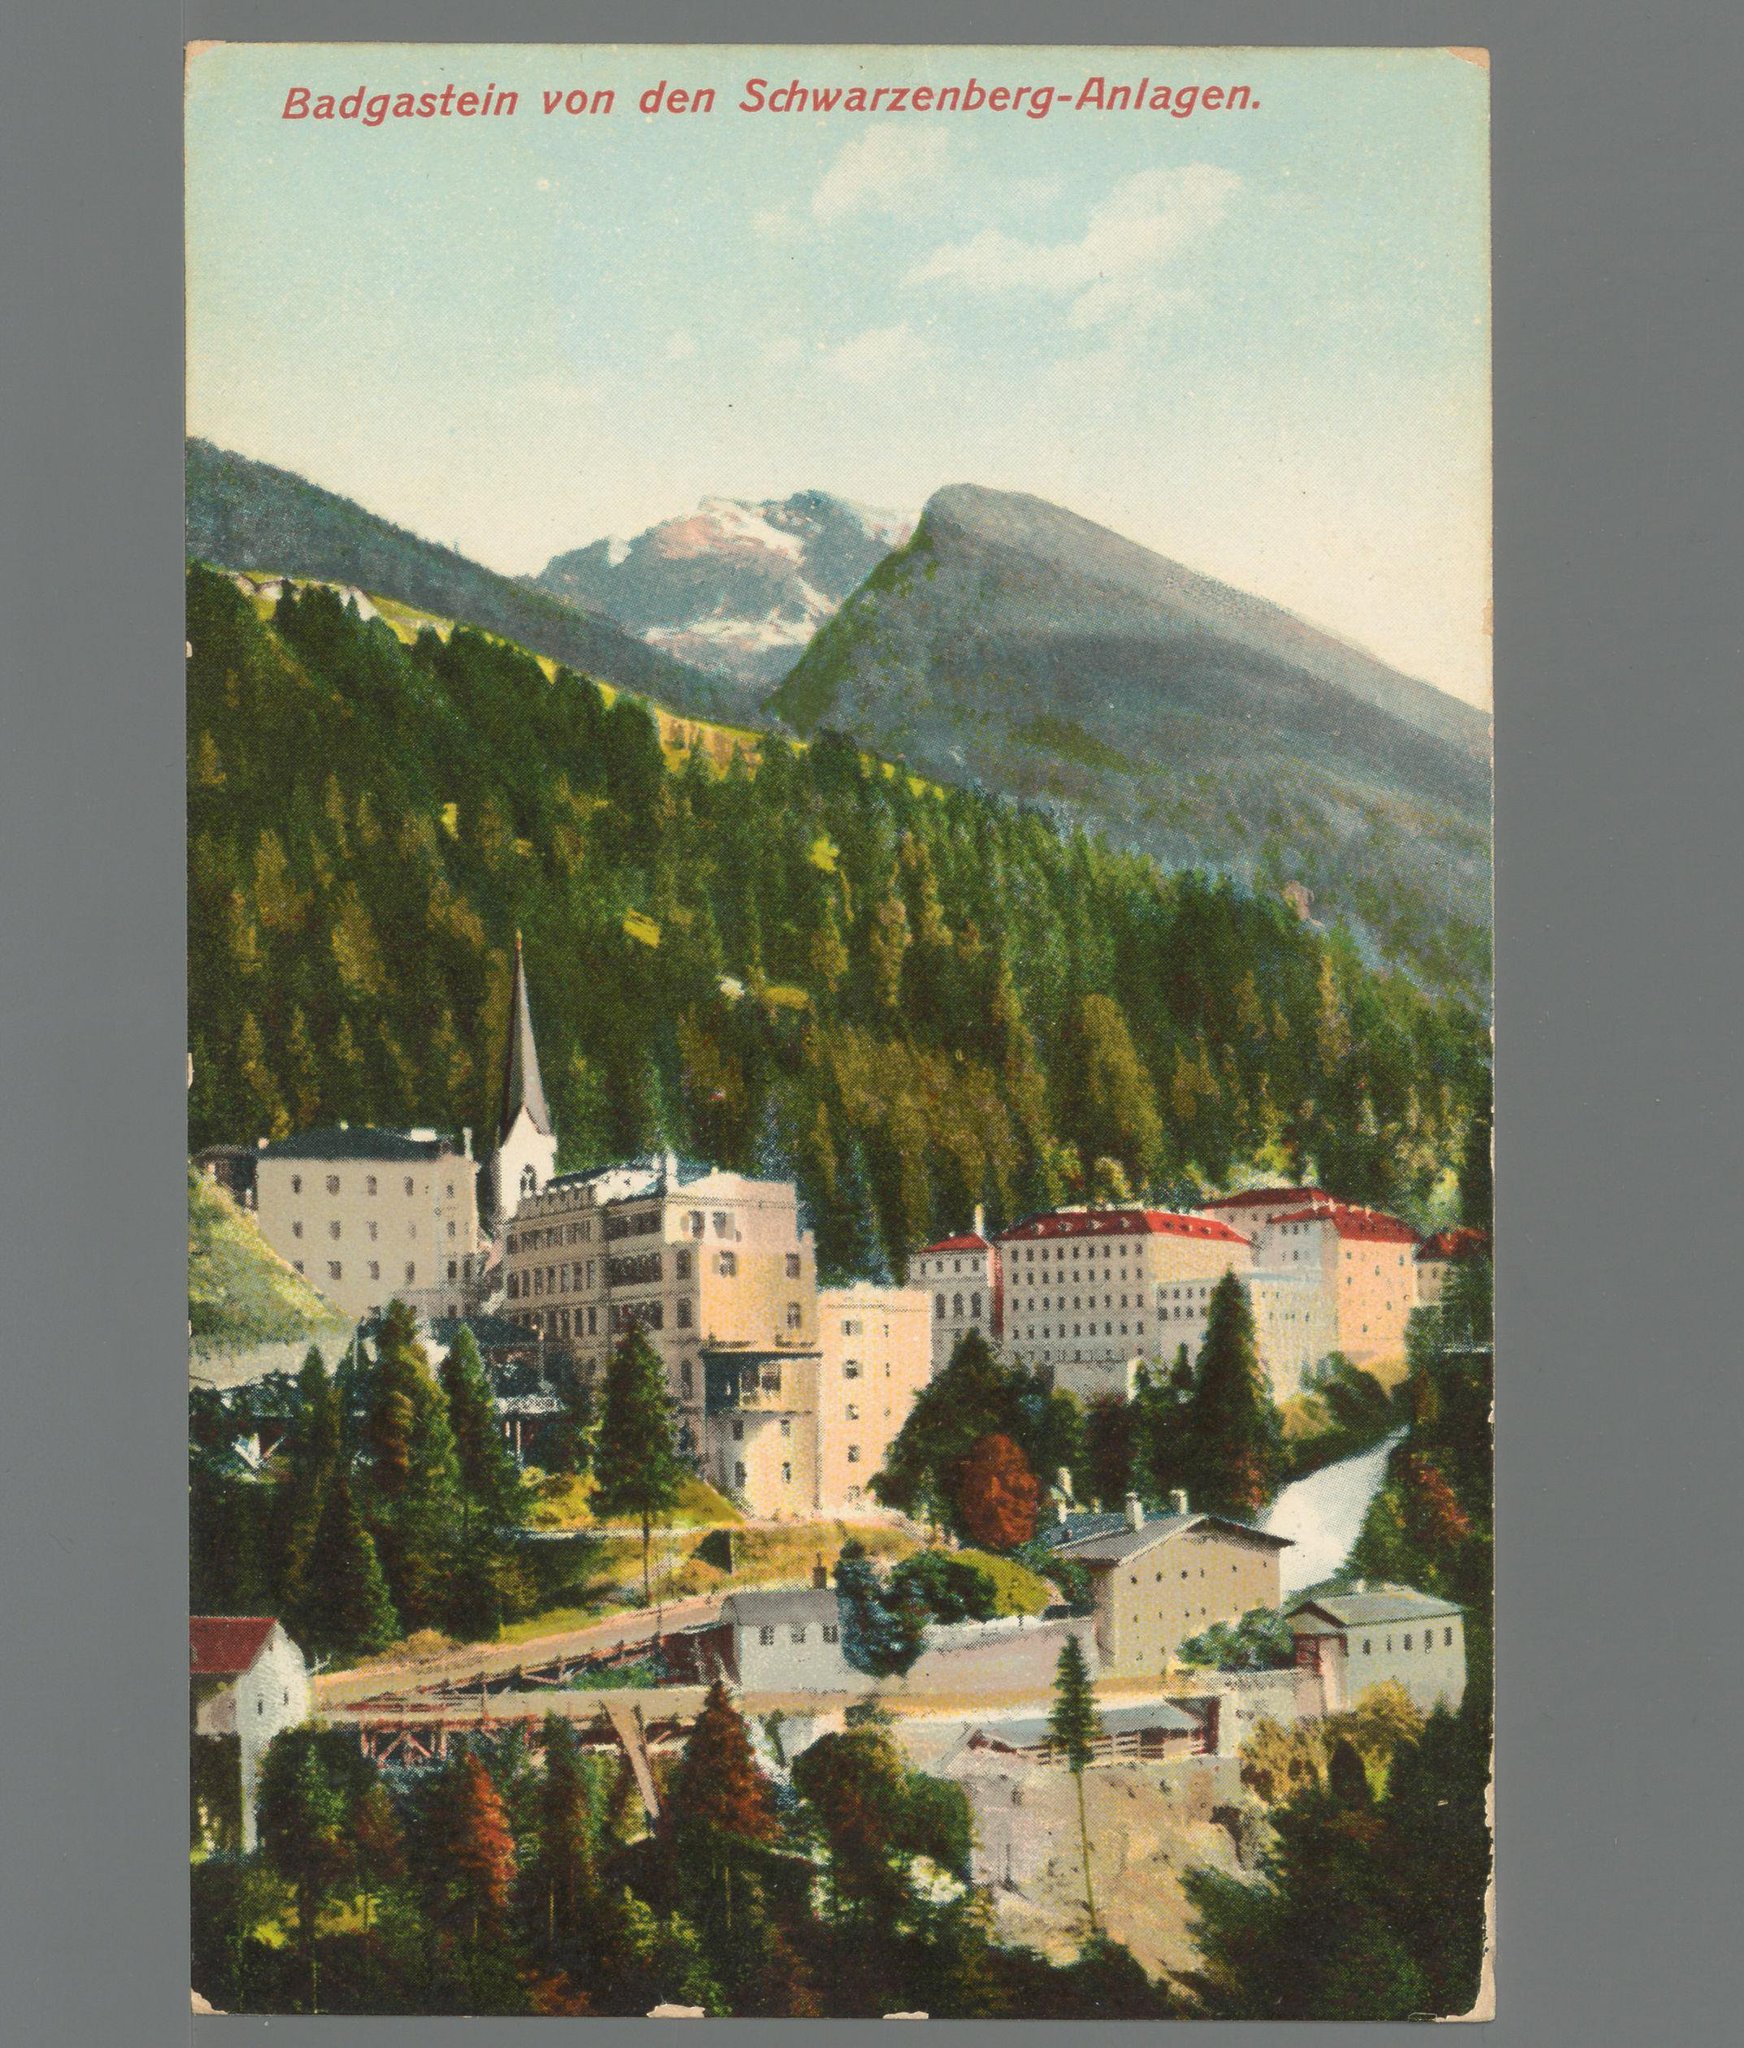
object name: ansichtkaart, prentbriefkaart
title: Badgastein von den Schwarzenberg-Anlagen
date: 1904-1909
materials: cardboard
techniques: lithograph, writing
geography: bad gastein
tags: dale, valley, church (exterior), mountains